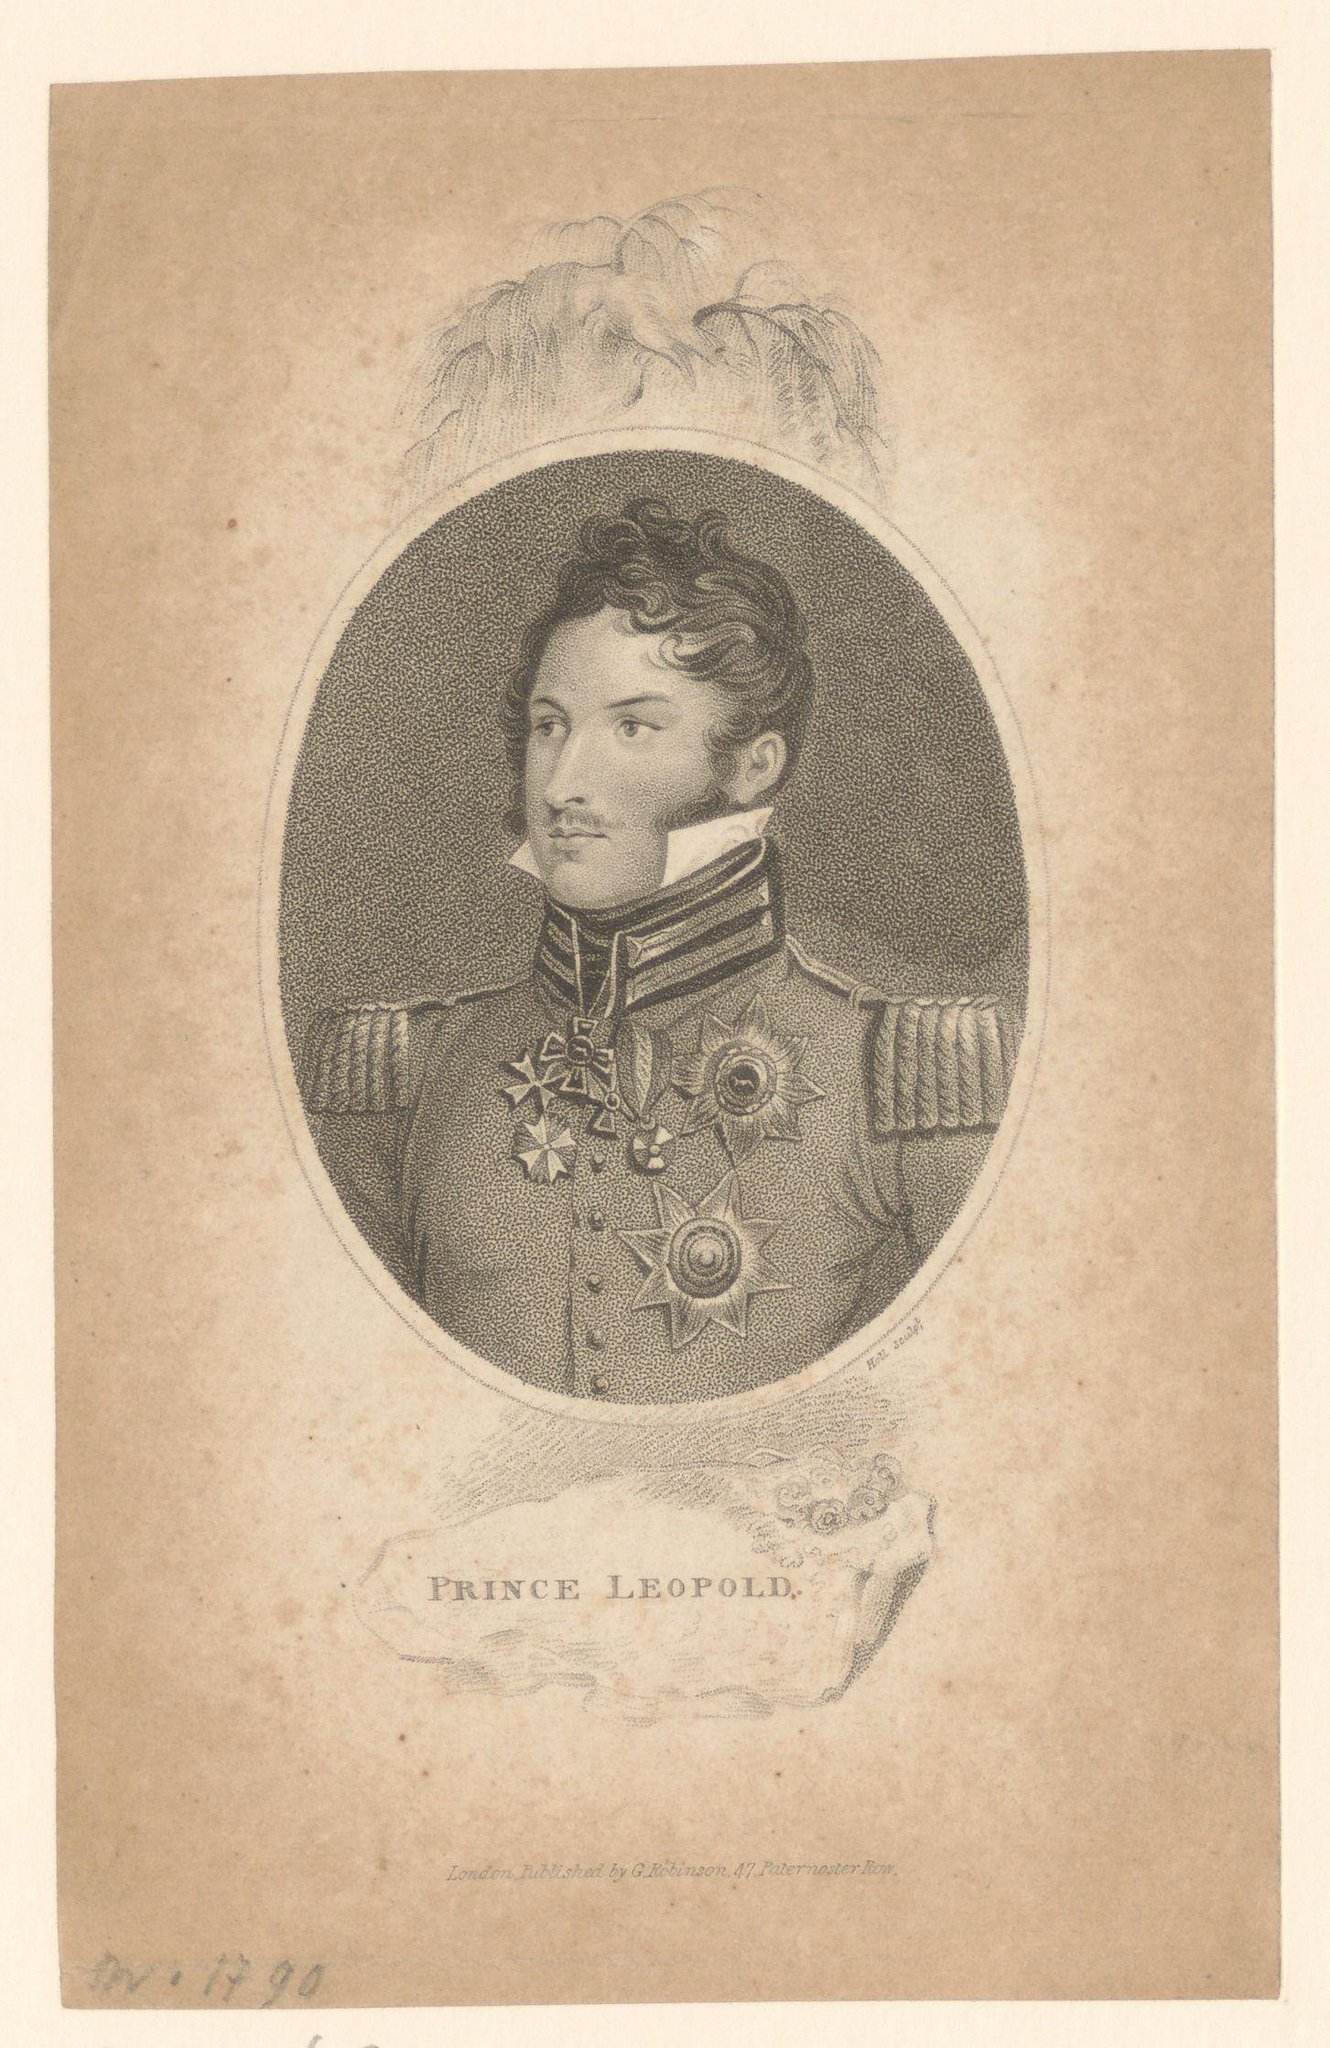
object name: print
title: Portret van Leopold I van België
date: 1806-1813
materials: paper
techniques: roulette, engraving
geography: england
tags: laeken, leopold i (koning der belgen), historical persons, king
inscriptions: collector's mark: Lugt 2228